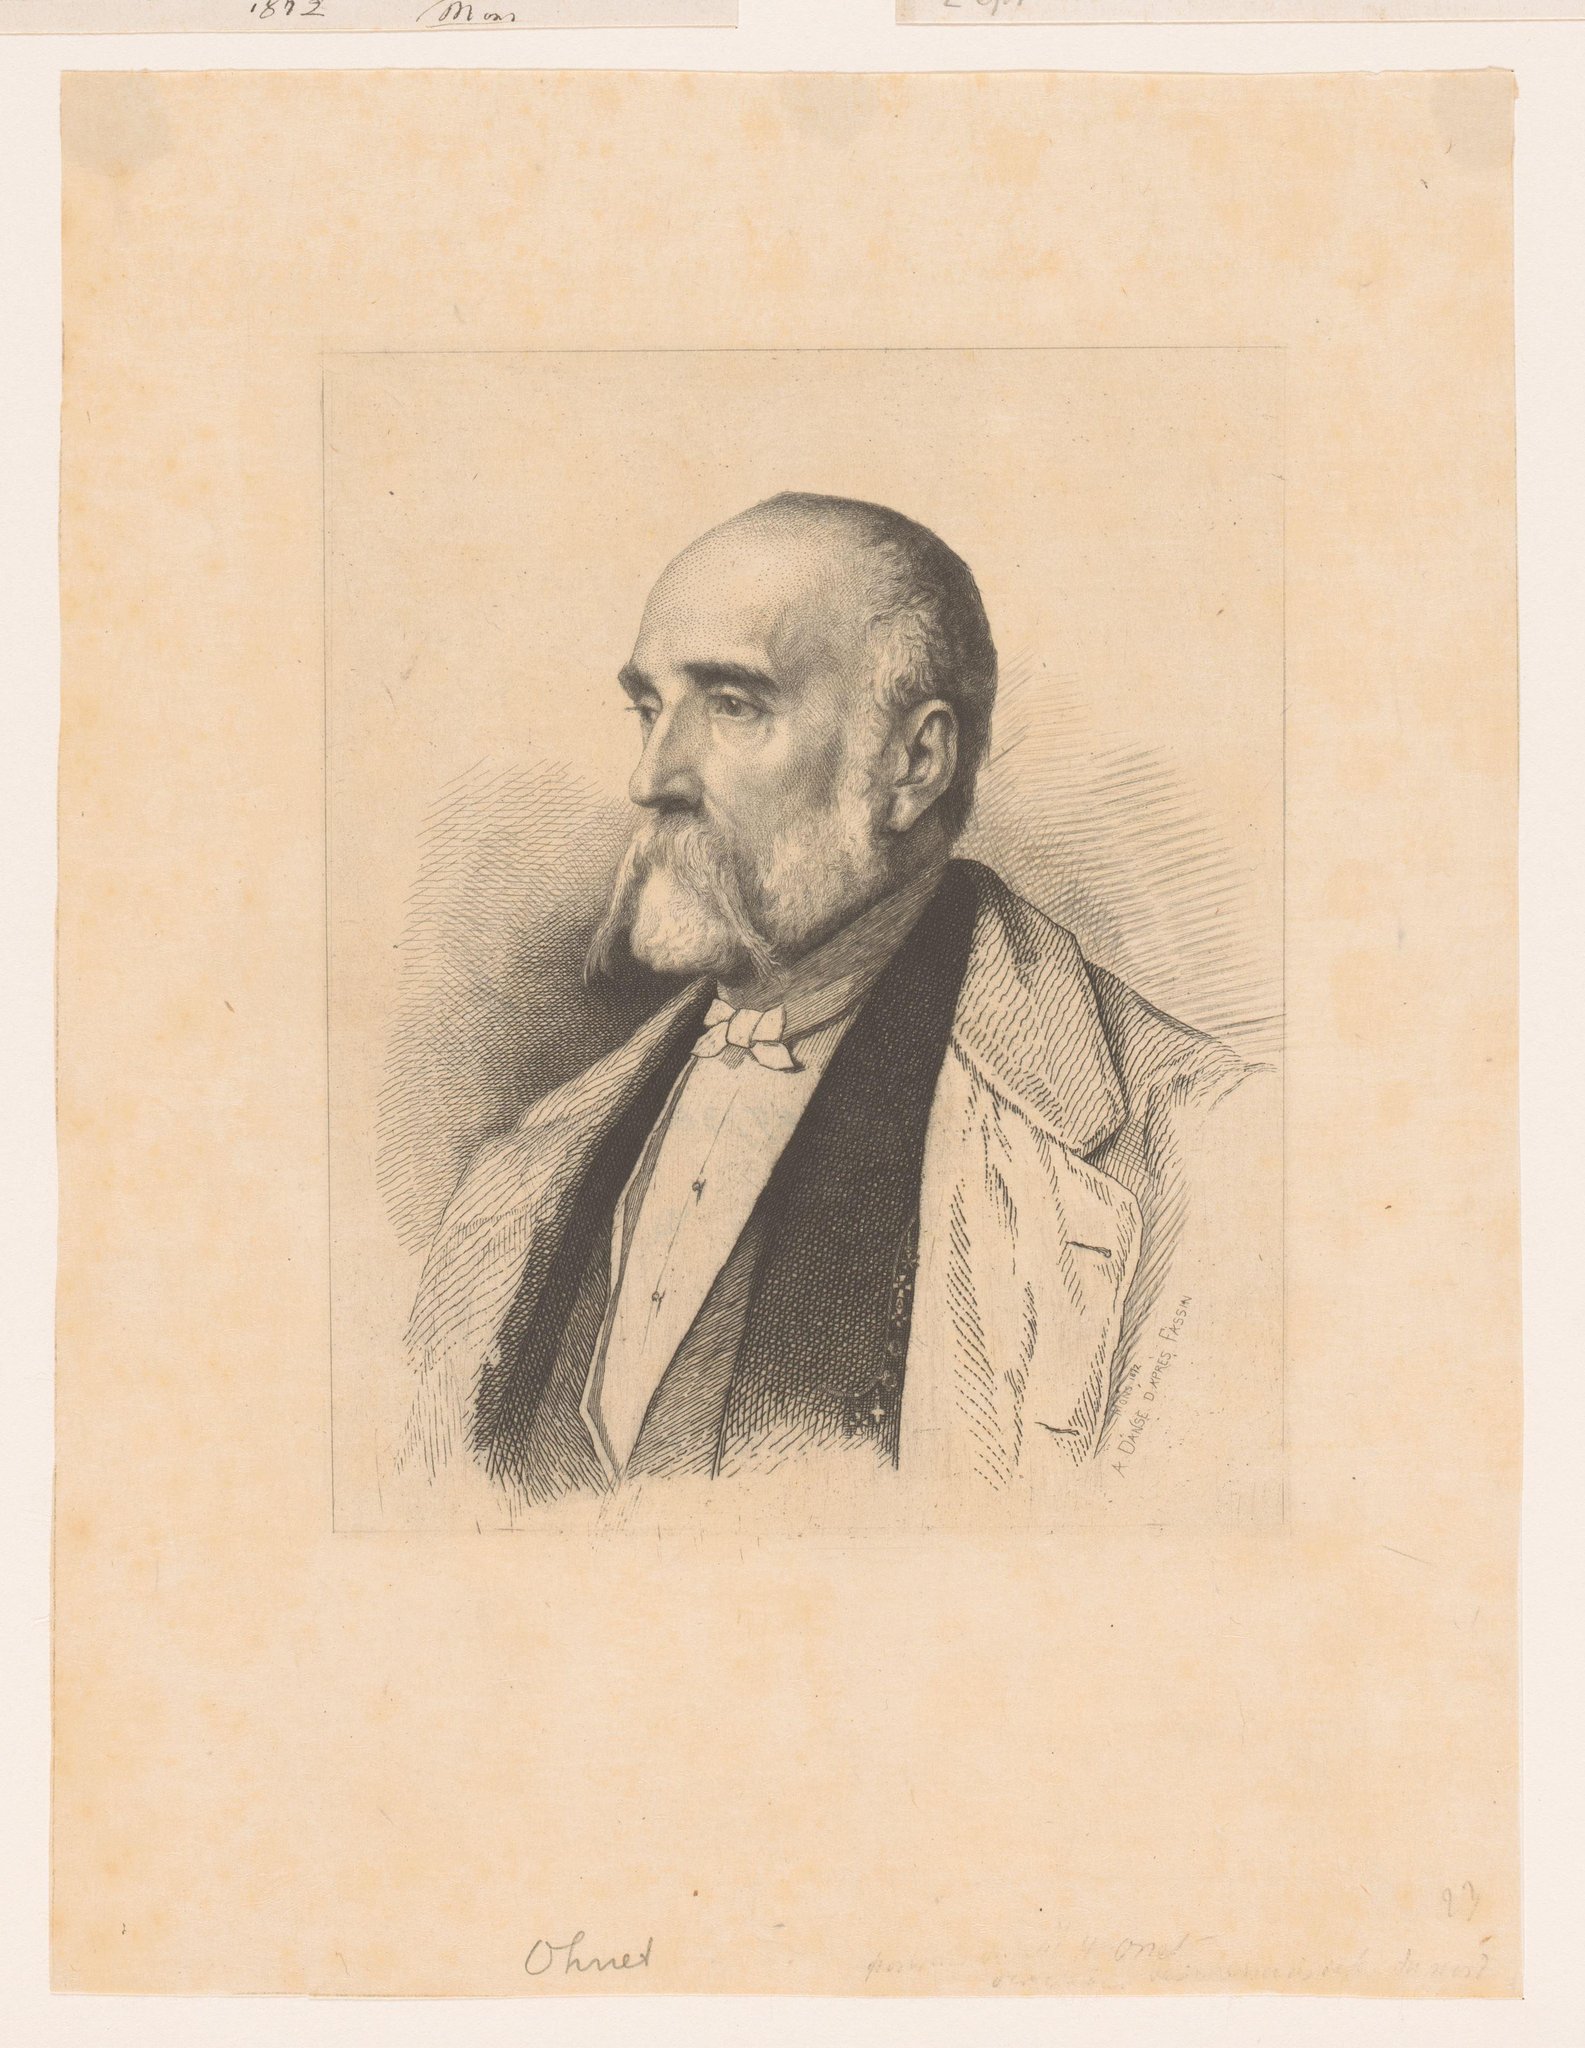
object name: print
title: Portret van een onbekende man genaamd Ohnet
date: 1872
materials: paper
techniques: drypoint, etching, intaglio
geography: bergen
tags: anonymous historical person portrayed alone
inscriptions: collector's mark: Lugt 2228